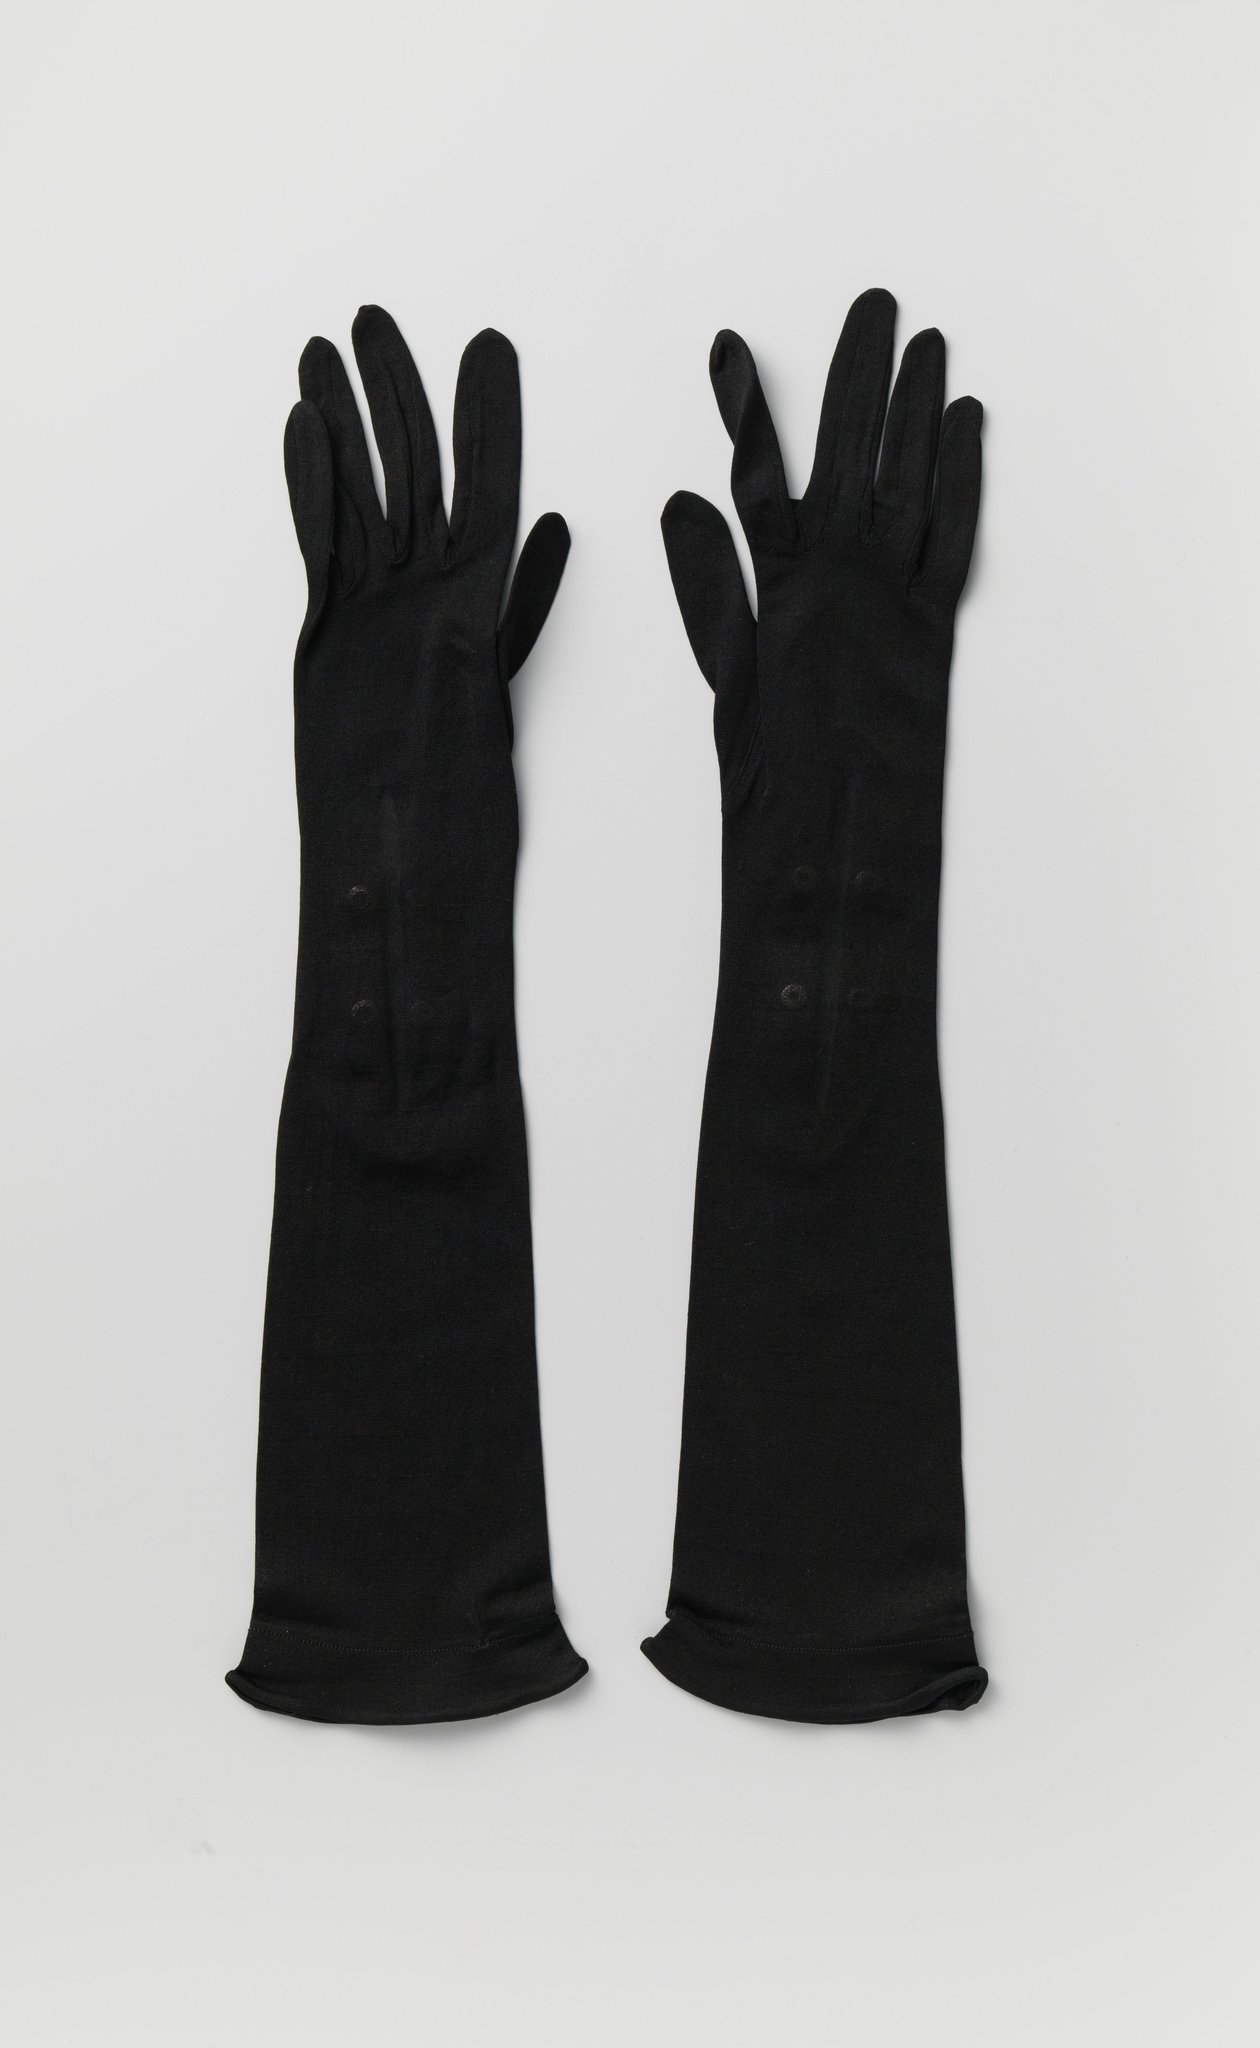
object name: clothing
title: Rouwhandschoen van zwarte zijden tricot met twee drukknopen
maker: Anonymous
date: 1920-1950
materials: silk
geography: western europe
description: Rechter handschoen van zwarte zijden tricot met licht ingewoven streepjes patroon. Bij de pols een split met twee drukknopen.